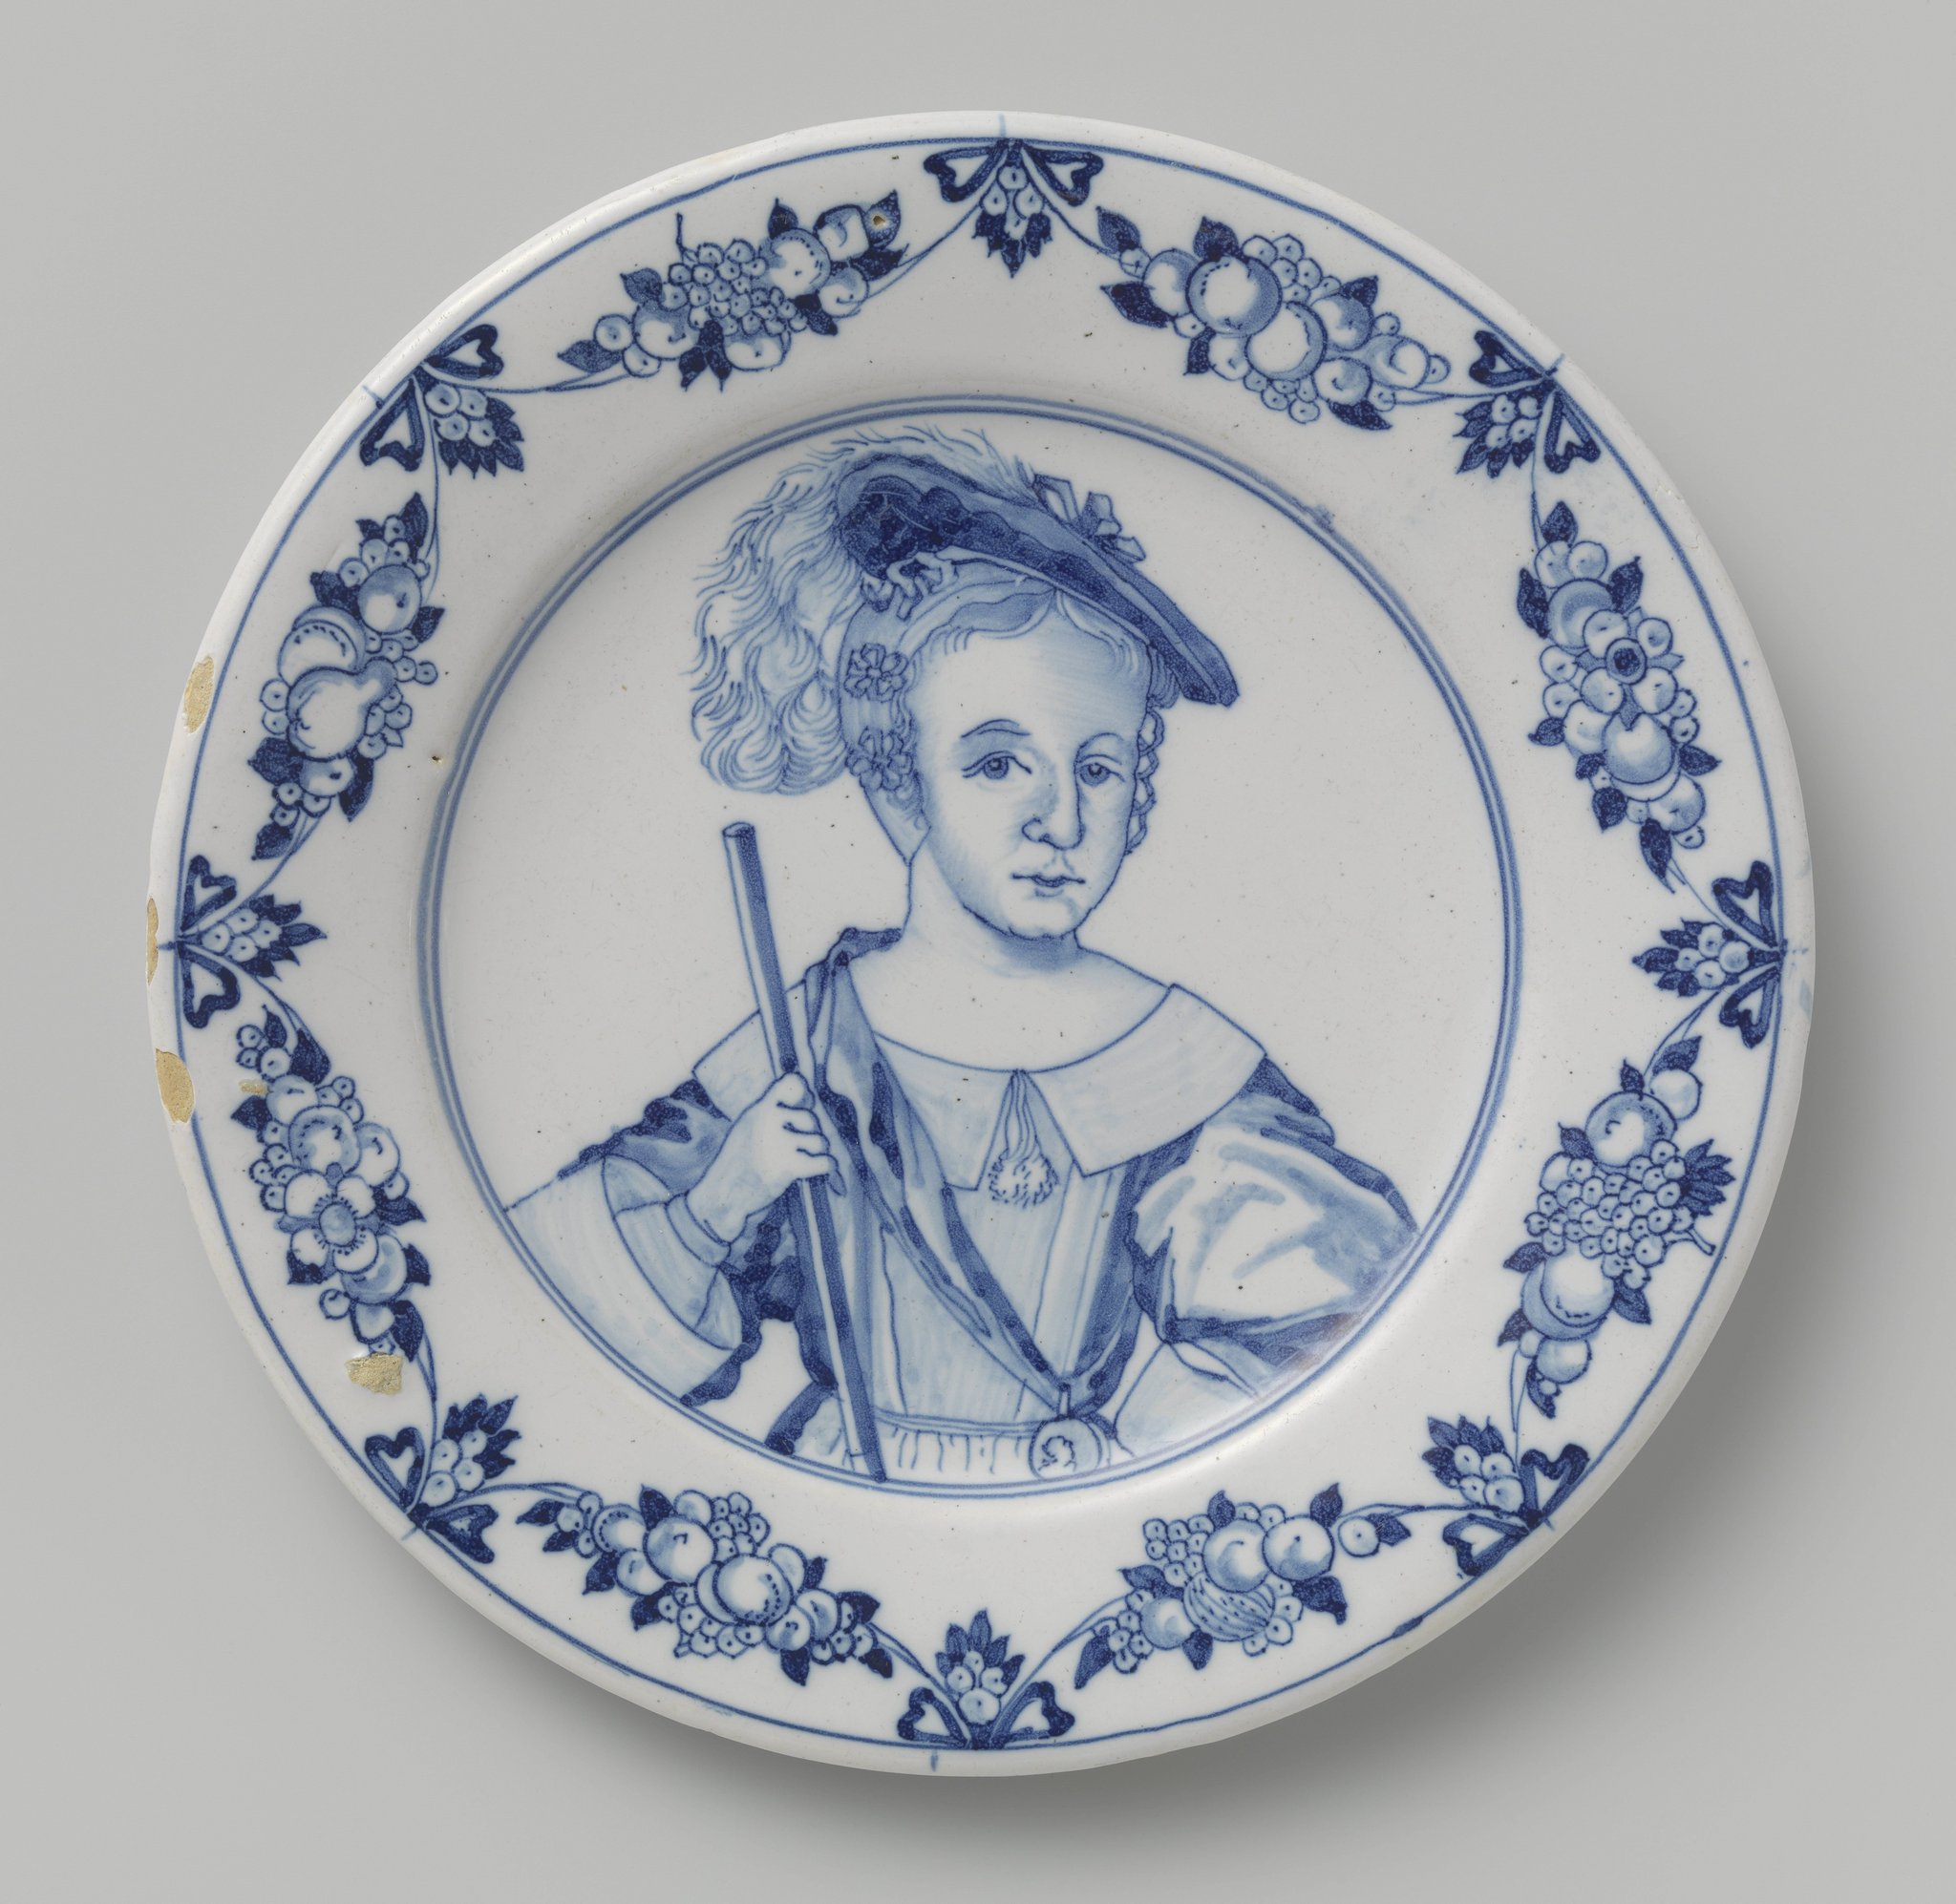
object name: plate dish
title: Dish with a Portrait of Prince William III as a Child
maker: Anonymous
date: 1658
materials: earthenware, glaze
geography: delft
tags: william iii (prince of orange and king of england, scotland, and ireland), crown prince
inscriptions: date: ‘1658’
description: Prince William III was eight years old when this dish with his portrait was made. The Delft pottery factories would continue to produce dishes and jugs with his portrait long after his death, not as royal commissions, but rather for private individuals intent on expressing their Orangist loyalties through such objects.